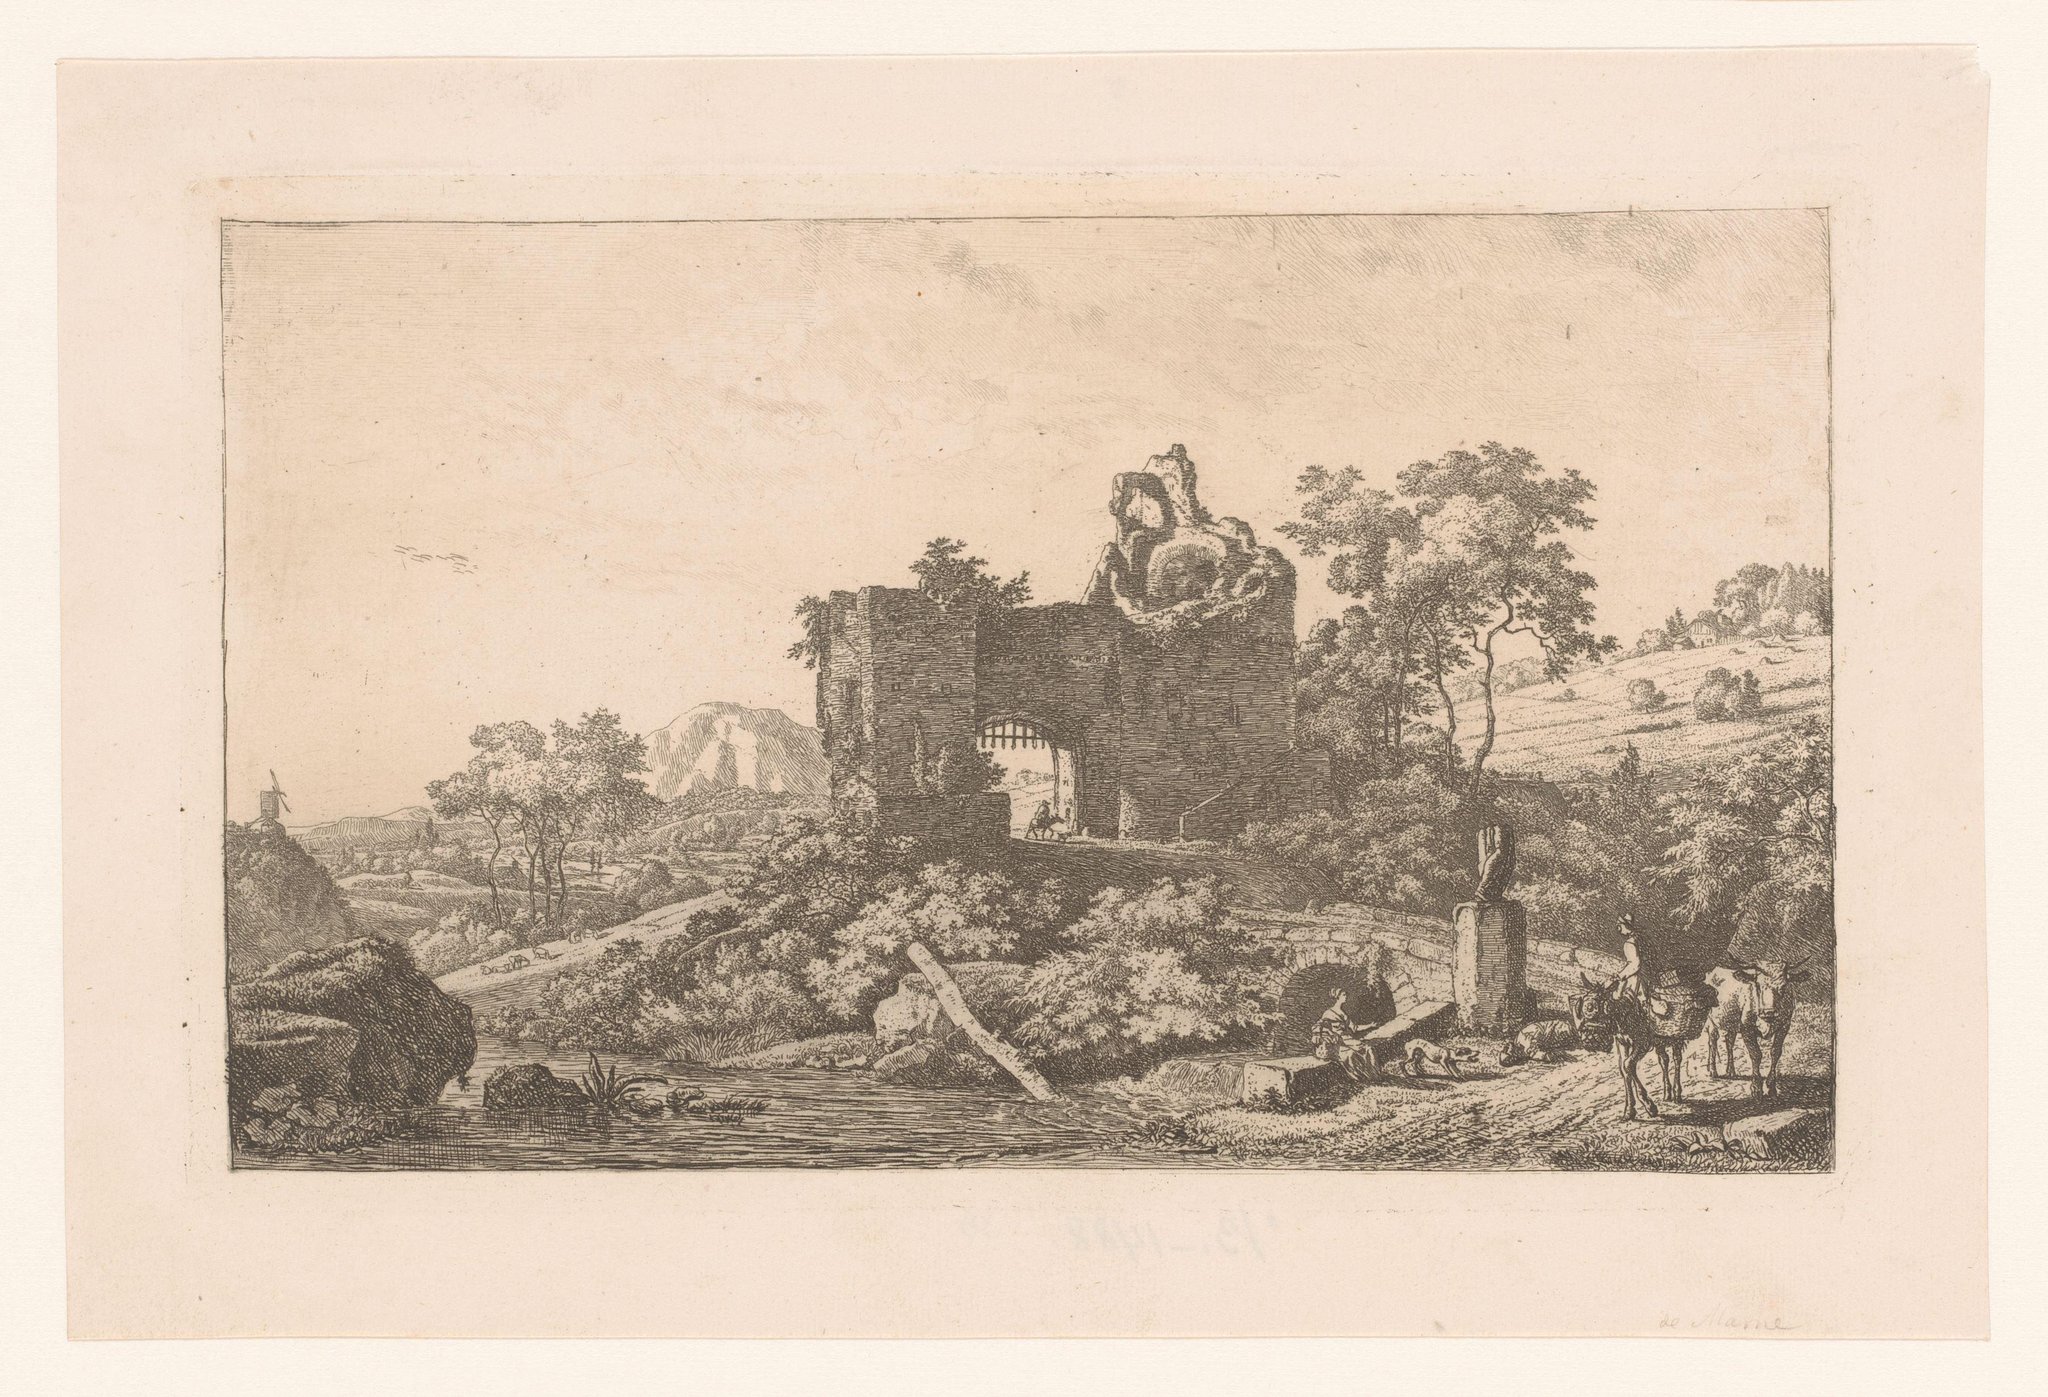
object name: print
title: Landschap met ruïne van een poort en figuren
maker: jean louis demarne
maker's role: draughtsman, painter, print maker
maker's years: 1752-1829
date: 1762-1829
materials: paper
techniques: etching, intaglio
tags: gate ~ fortified city, landscape with ruins (+ city(-scape) with figures, staffage)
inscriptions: collector's mark: Lugt 2228, collector's mark: Lugt 1485